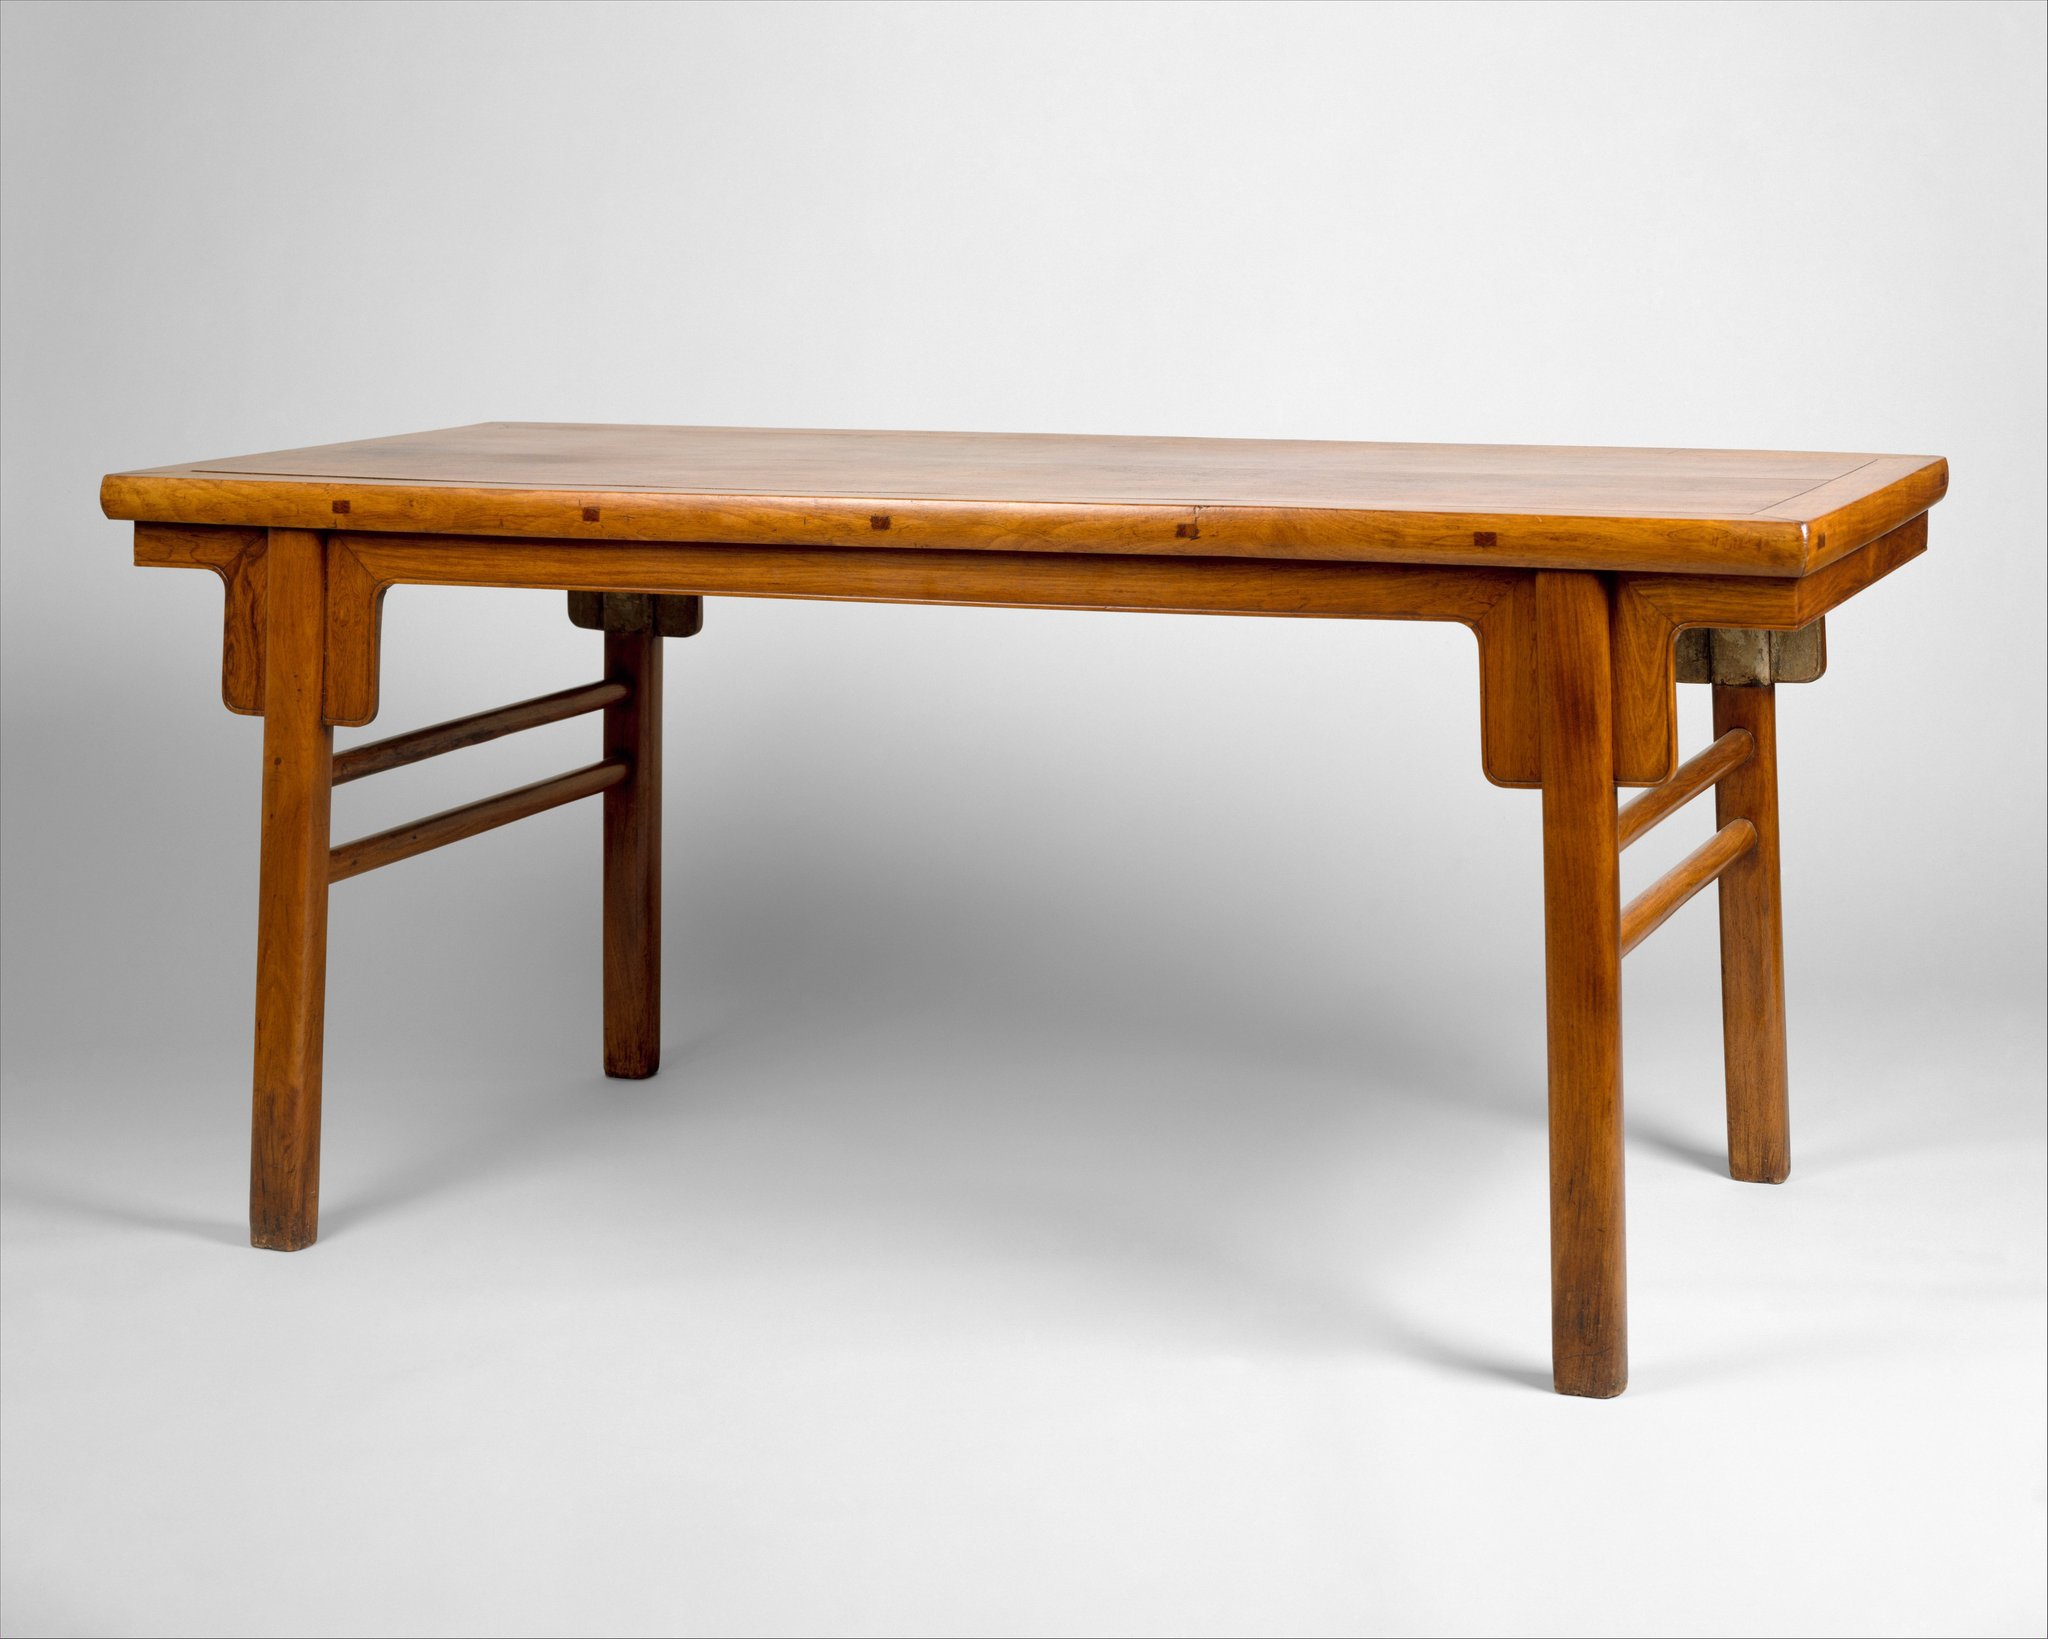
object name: table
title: Painting table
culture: chinese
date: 1567-1633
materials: wood